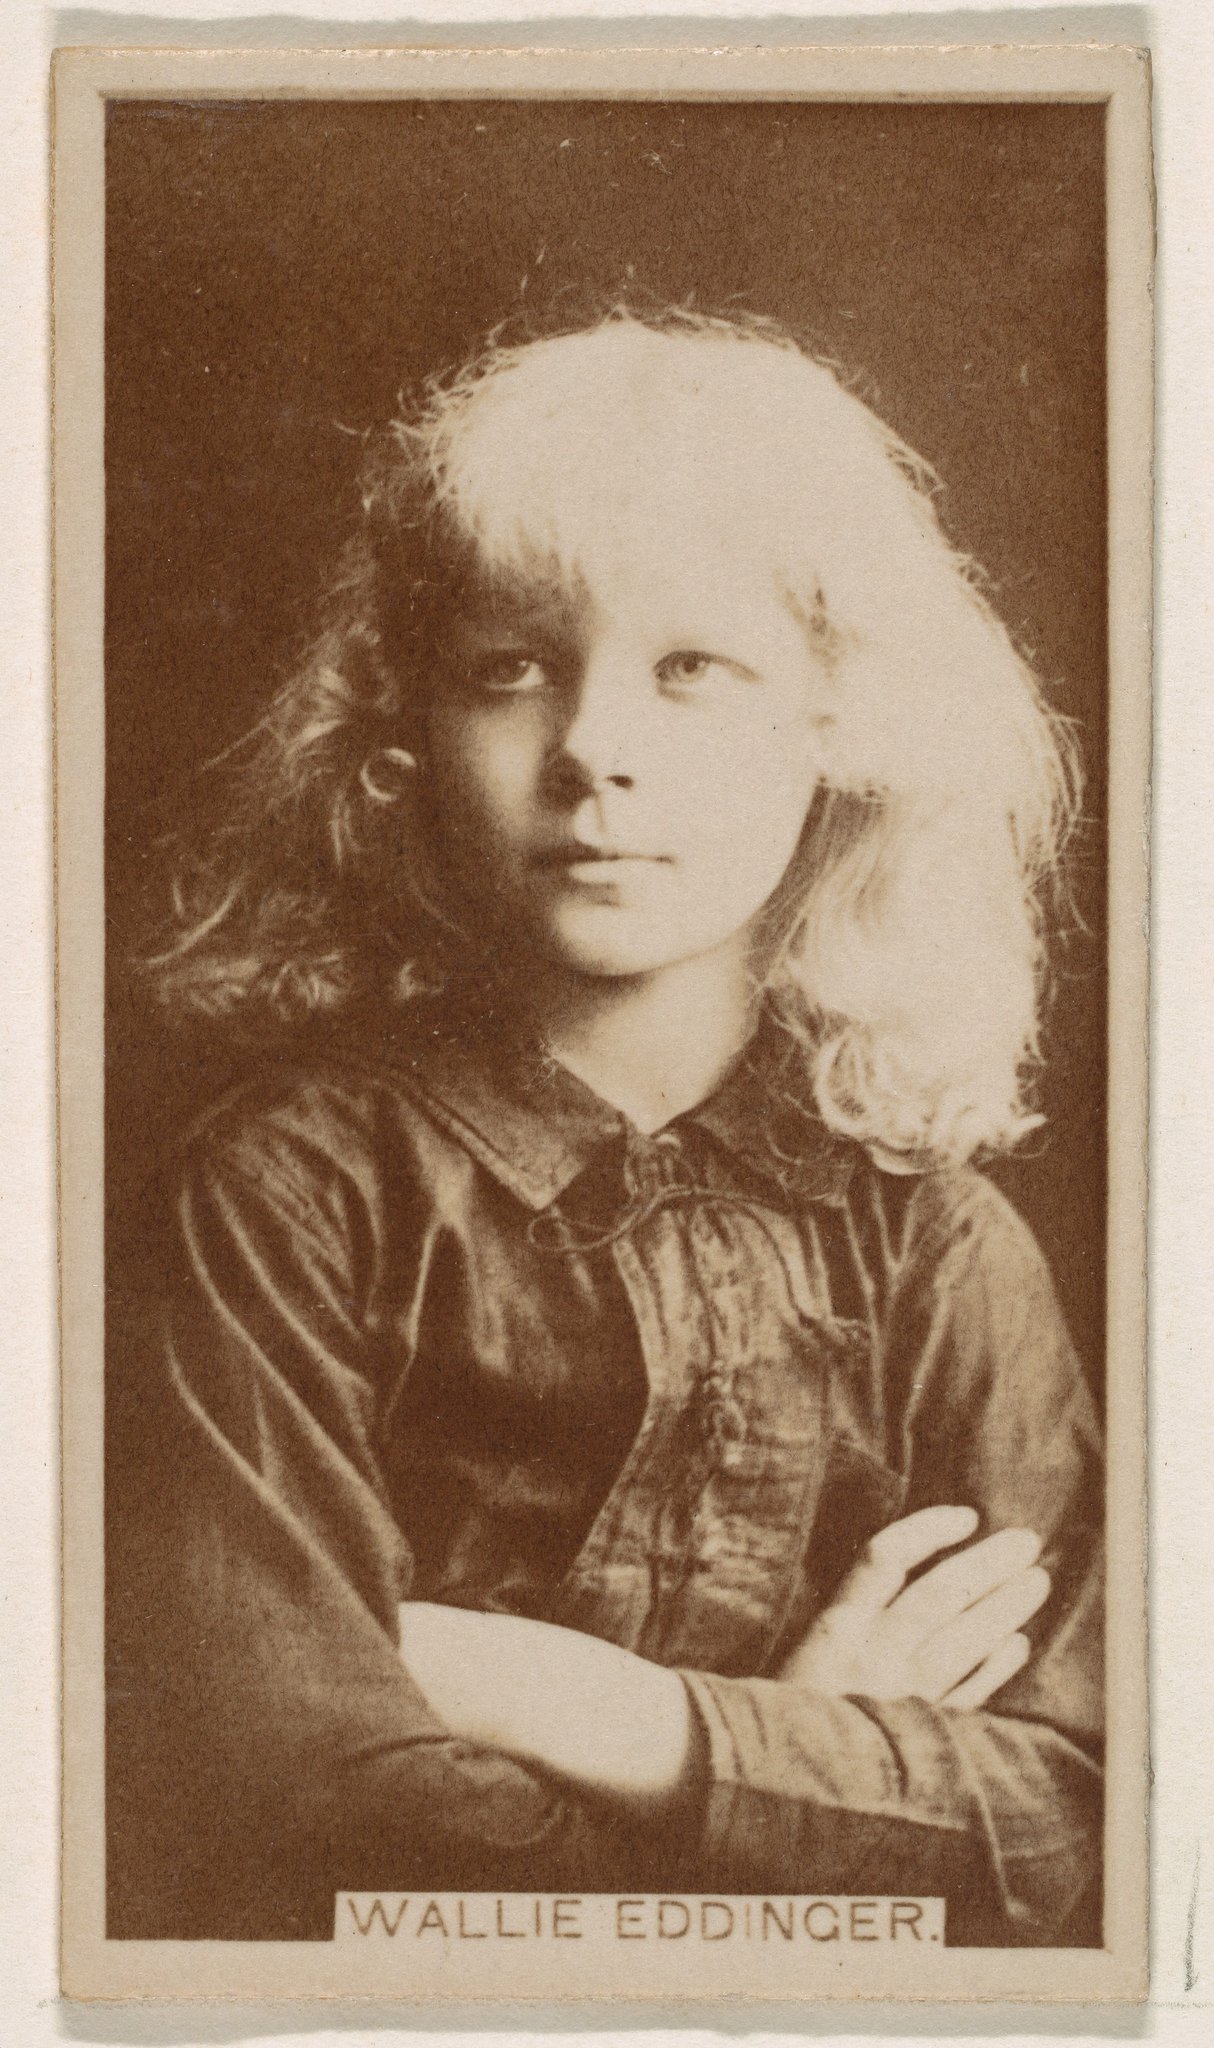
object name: photograph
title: Wallie Eddinger, from the Actresses series (N245) issued by Kinney Brothers to promote Sweet Caporal Cigarettes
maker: kinney brothers tobacco company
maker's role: publisher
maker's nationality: american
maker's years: 1869-2011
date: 1890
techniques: albumen silver print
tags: girls,portraits,actors